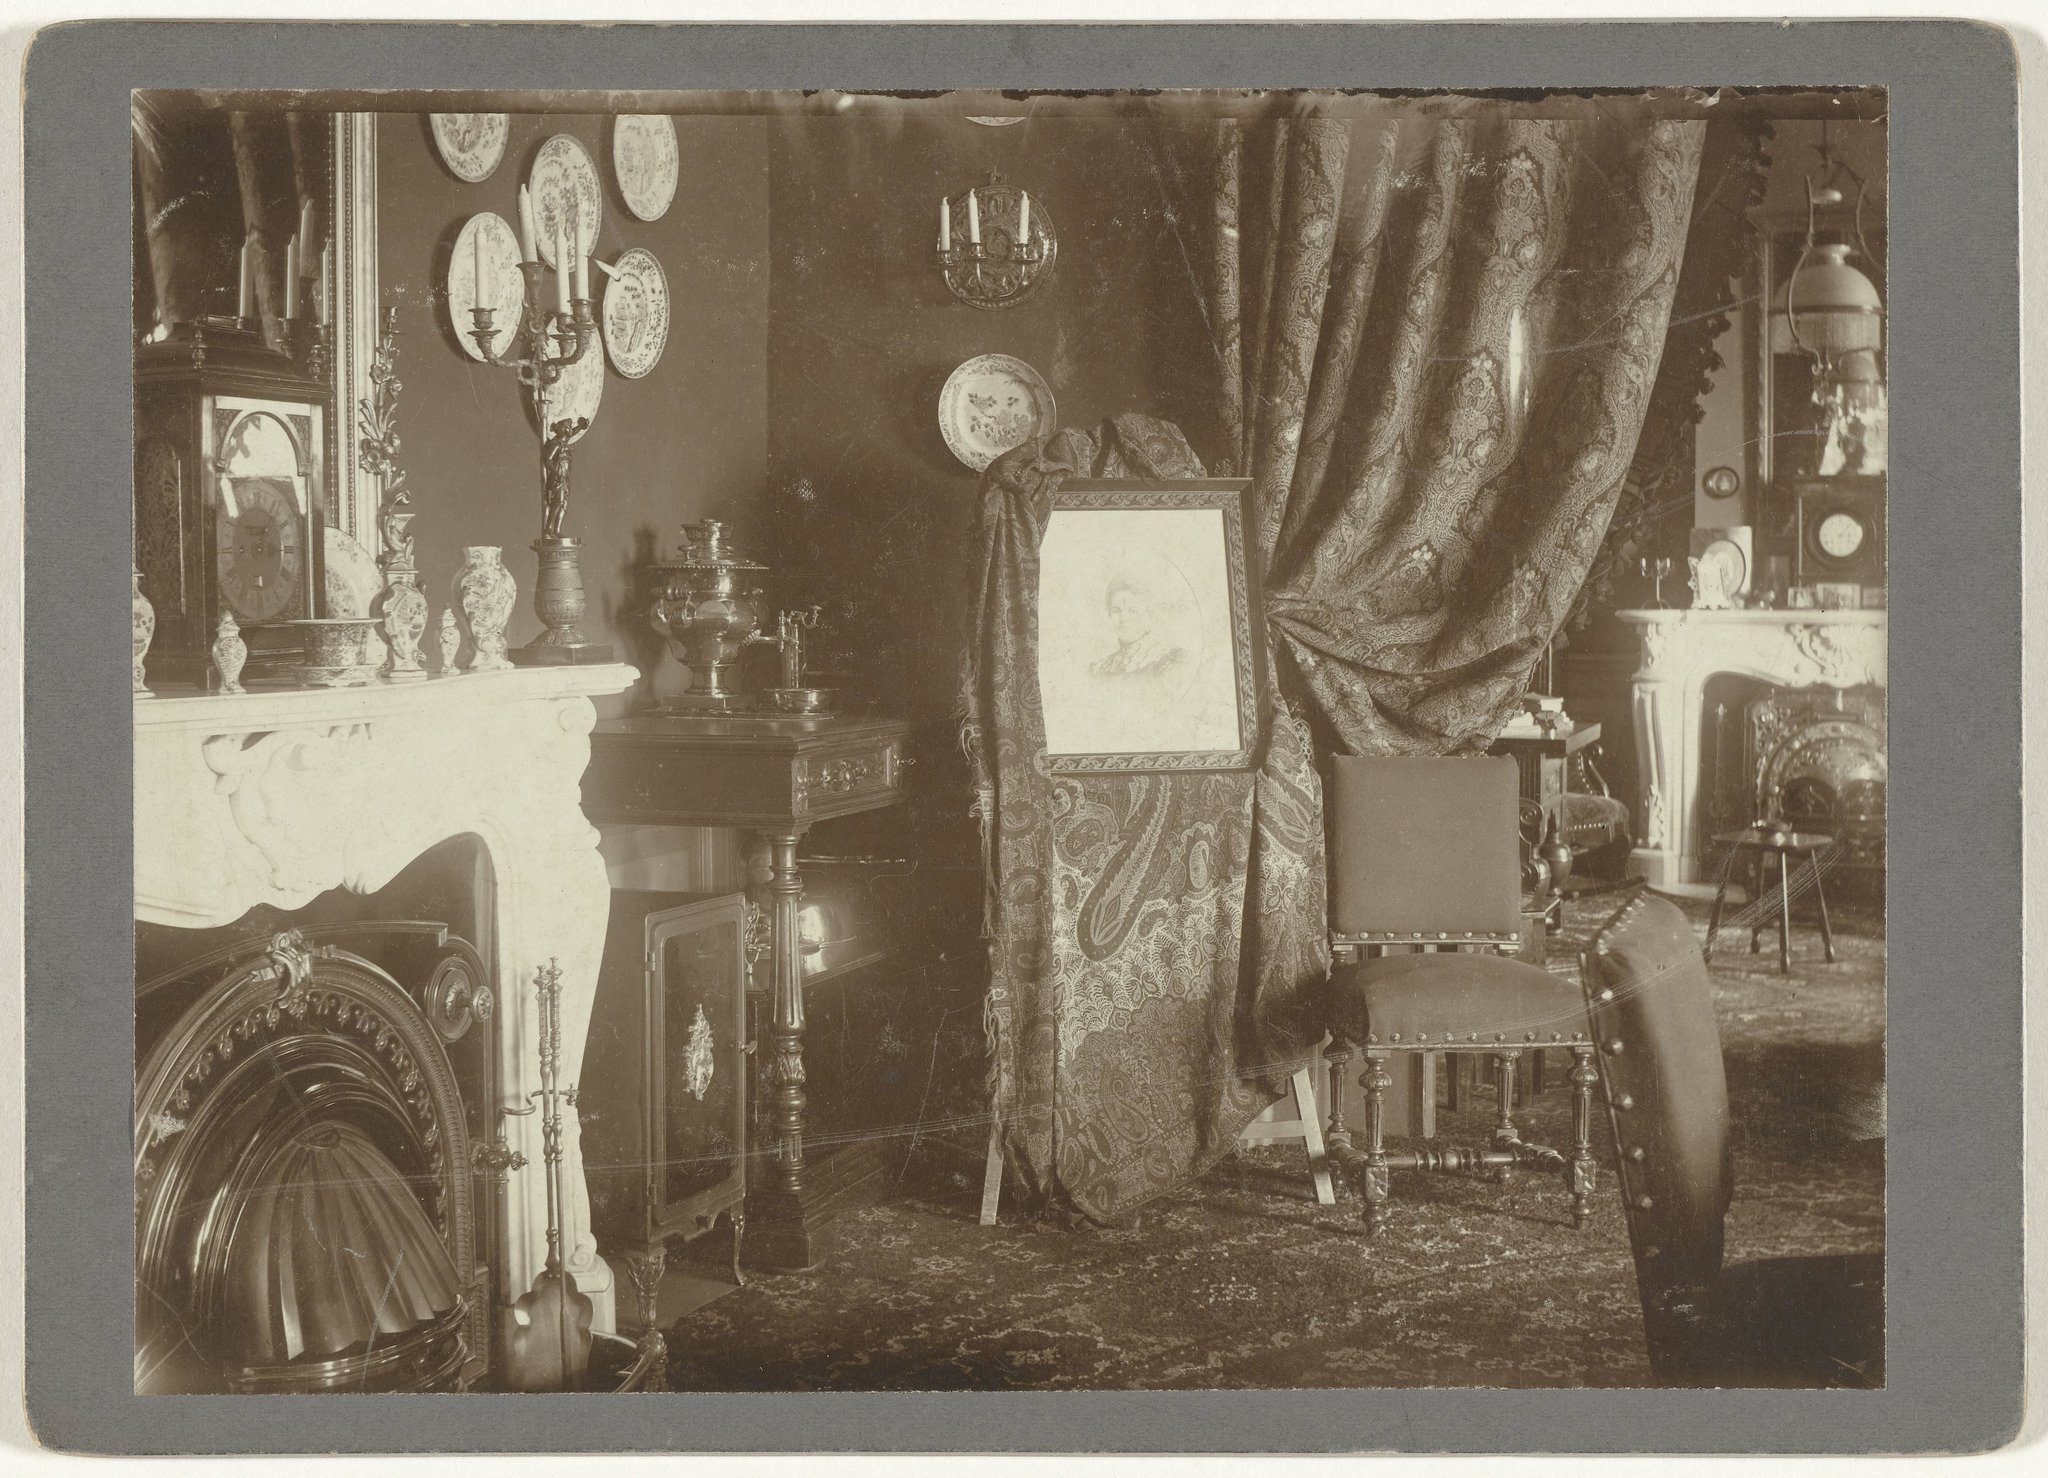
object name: photograph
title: Interieur van het huis van W.H. van Braam in Arnhem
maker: Anonymous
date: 1880-1900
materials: paper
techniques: albumen print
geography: netherlands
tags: manufacturer, willem hendrik van braam, interior of the house, arnhem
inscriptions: title: ‘De Kraton, huis W.H. v. Braam te Arnhem’